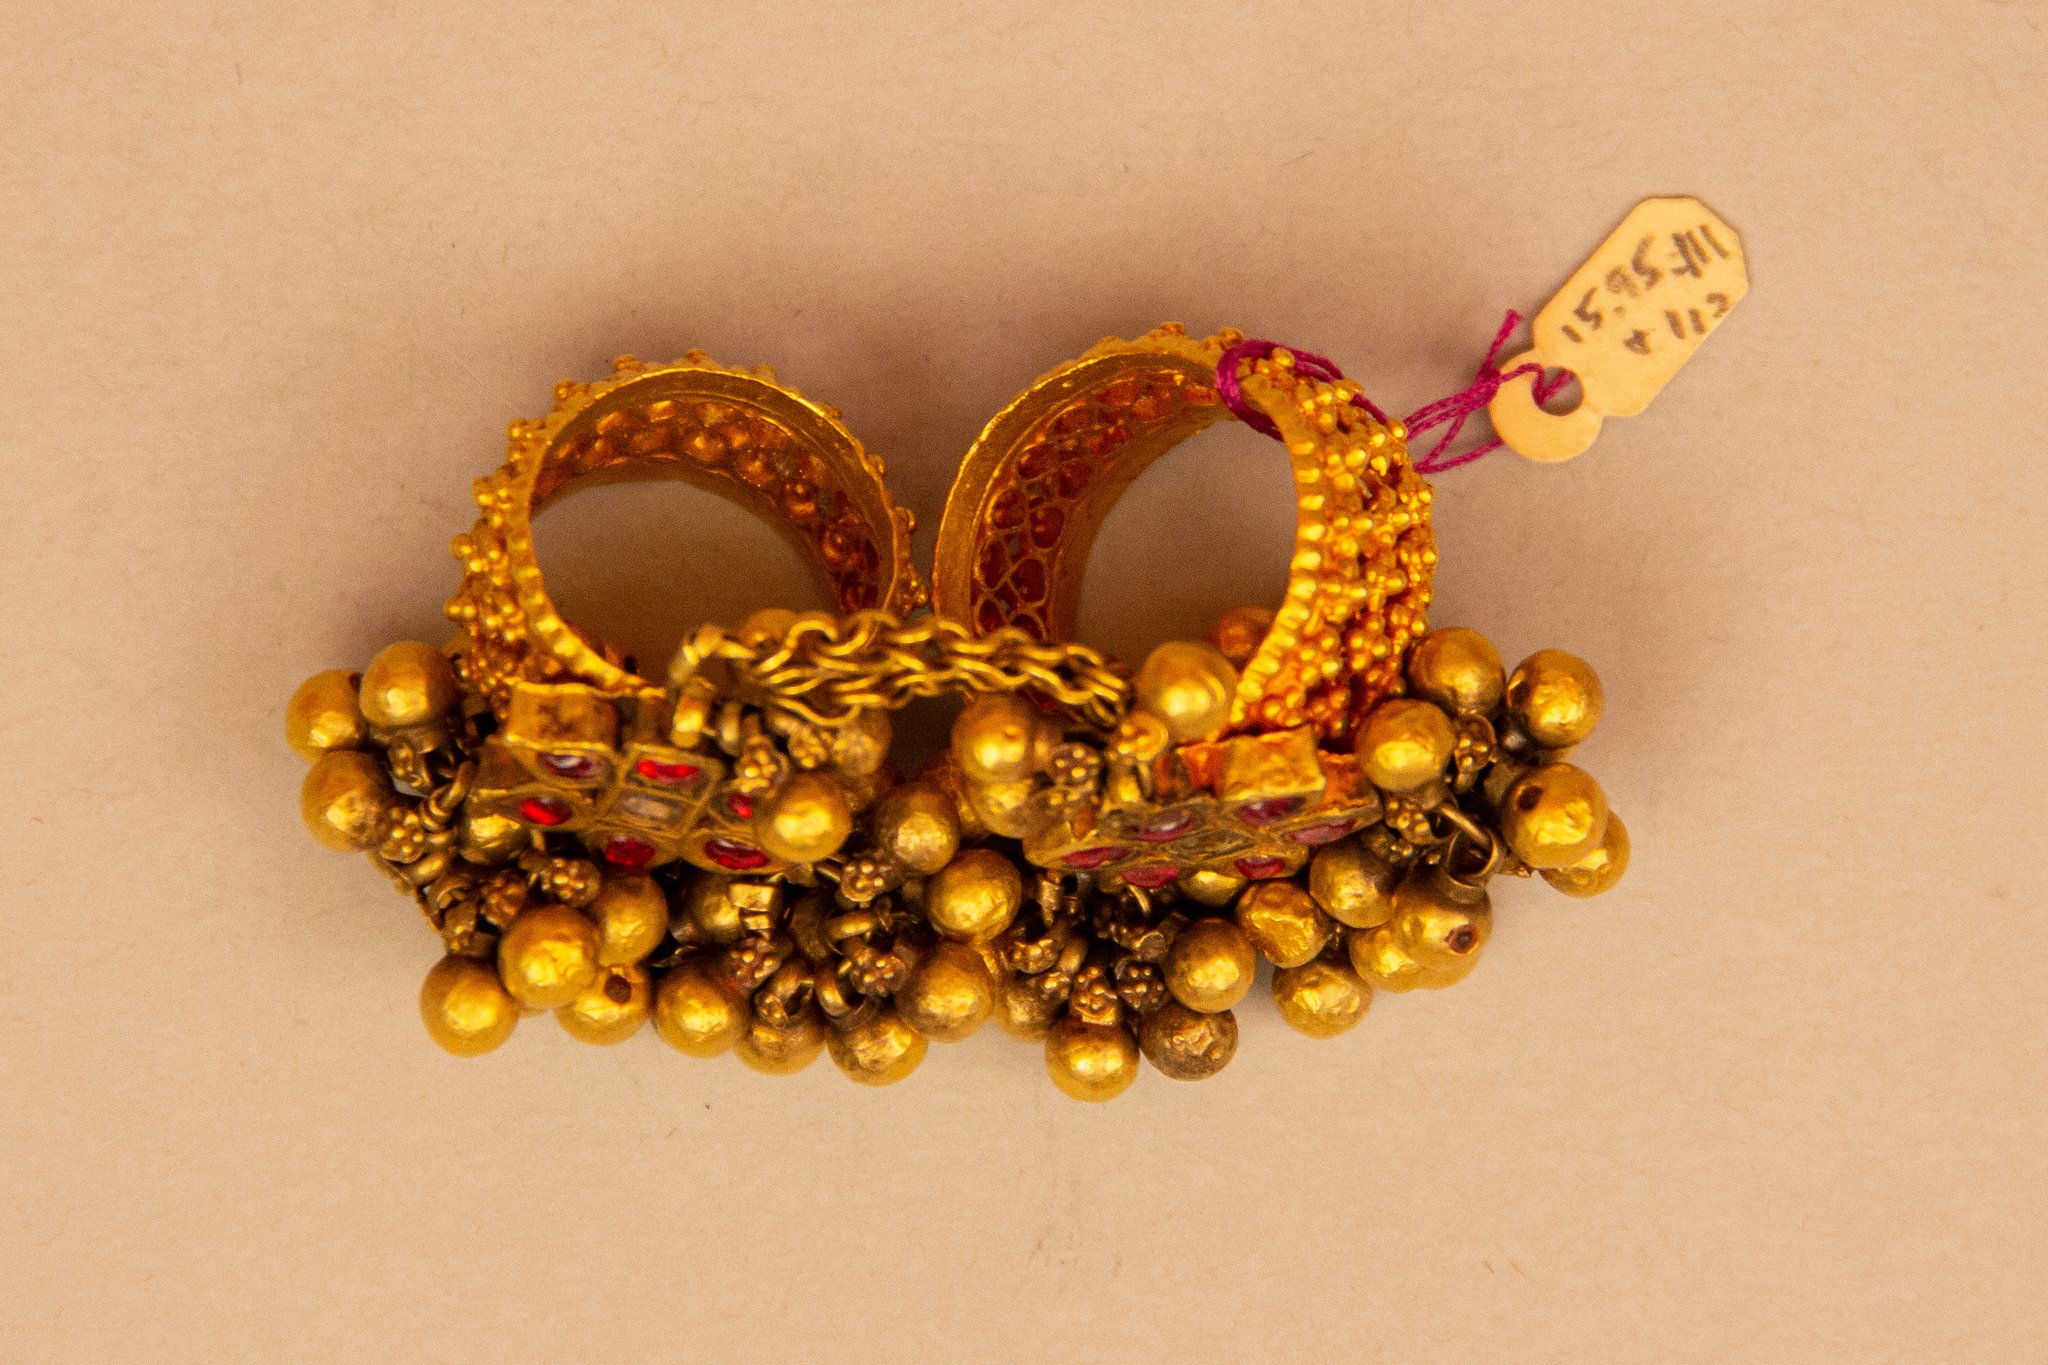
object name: ring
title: Ring, One of a Pair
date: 1701-1900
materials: gold, gemstone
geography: northern india